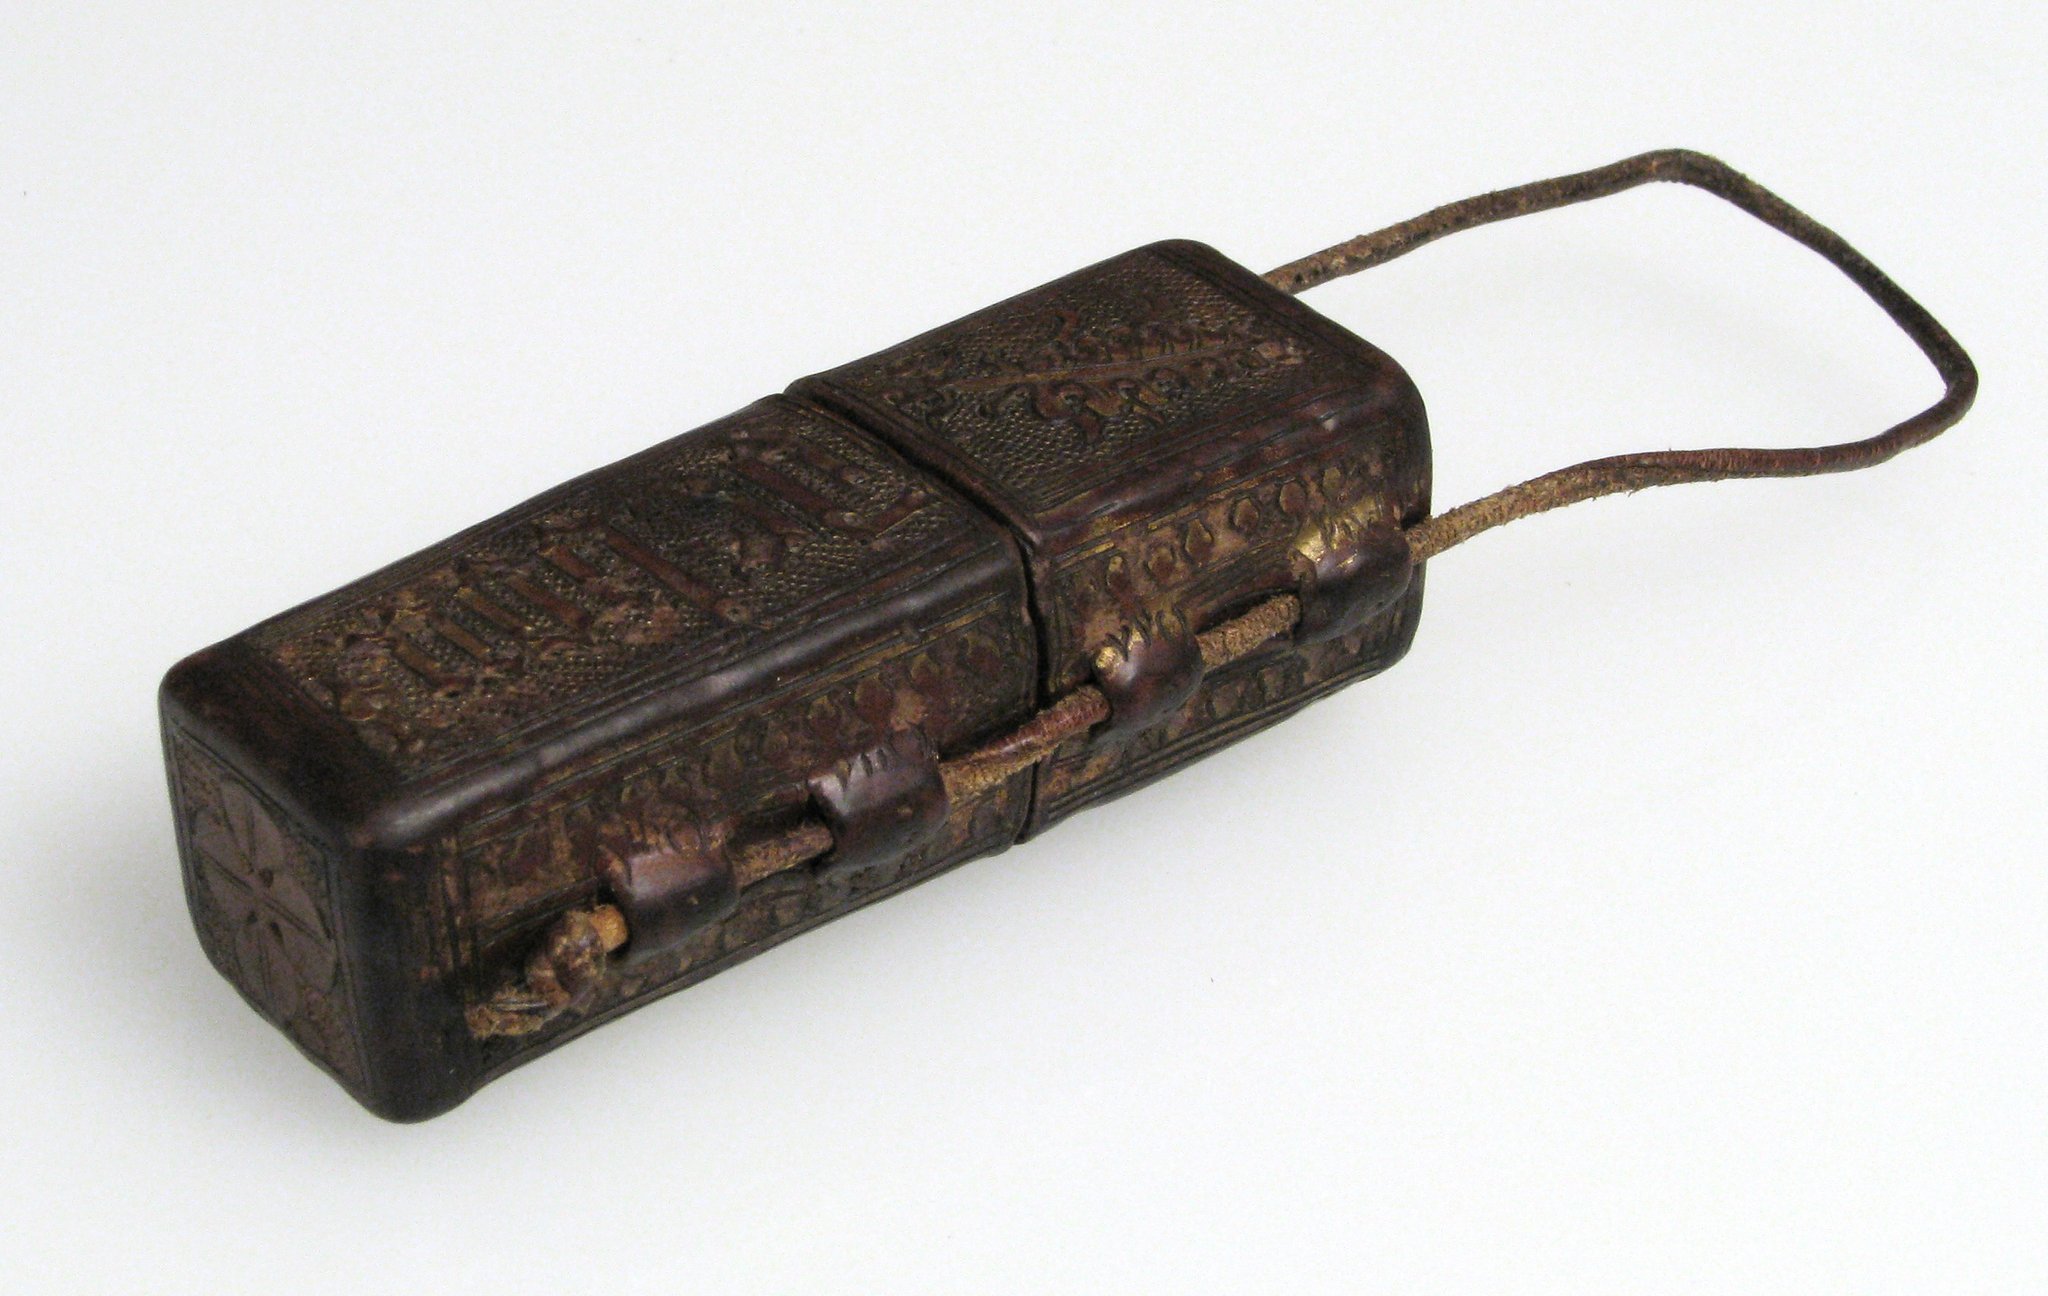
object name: reliquary case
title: Portable Reliquary Case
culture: french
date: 1400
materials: leather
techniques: gilding, tooling